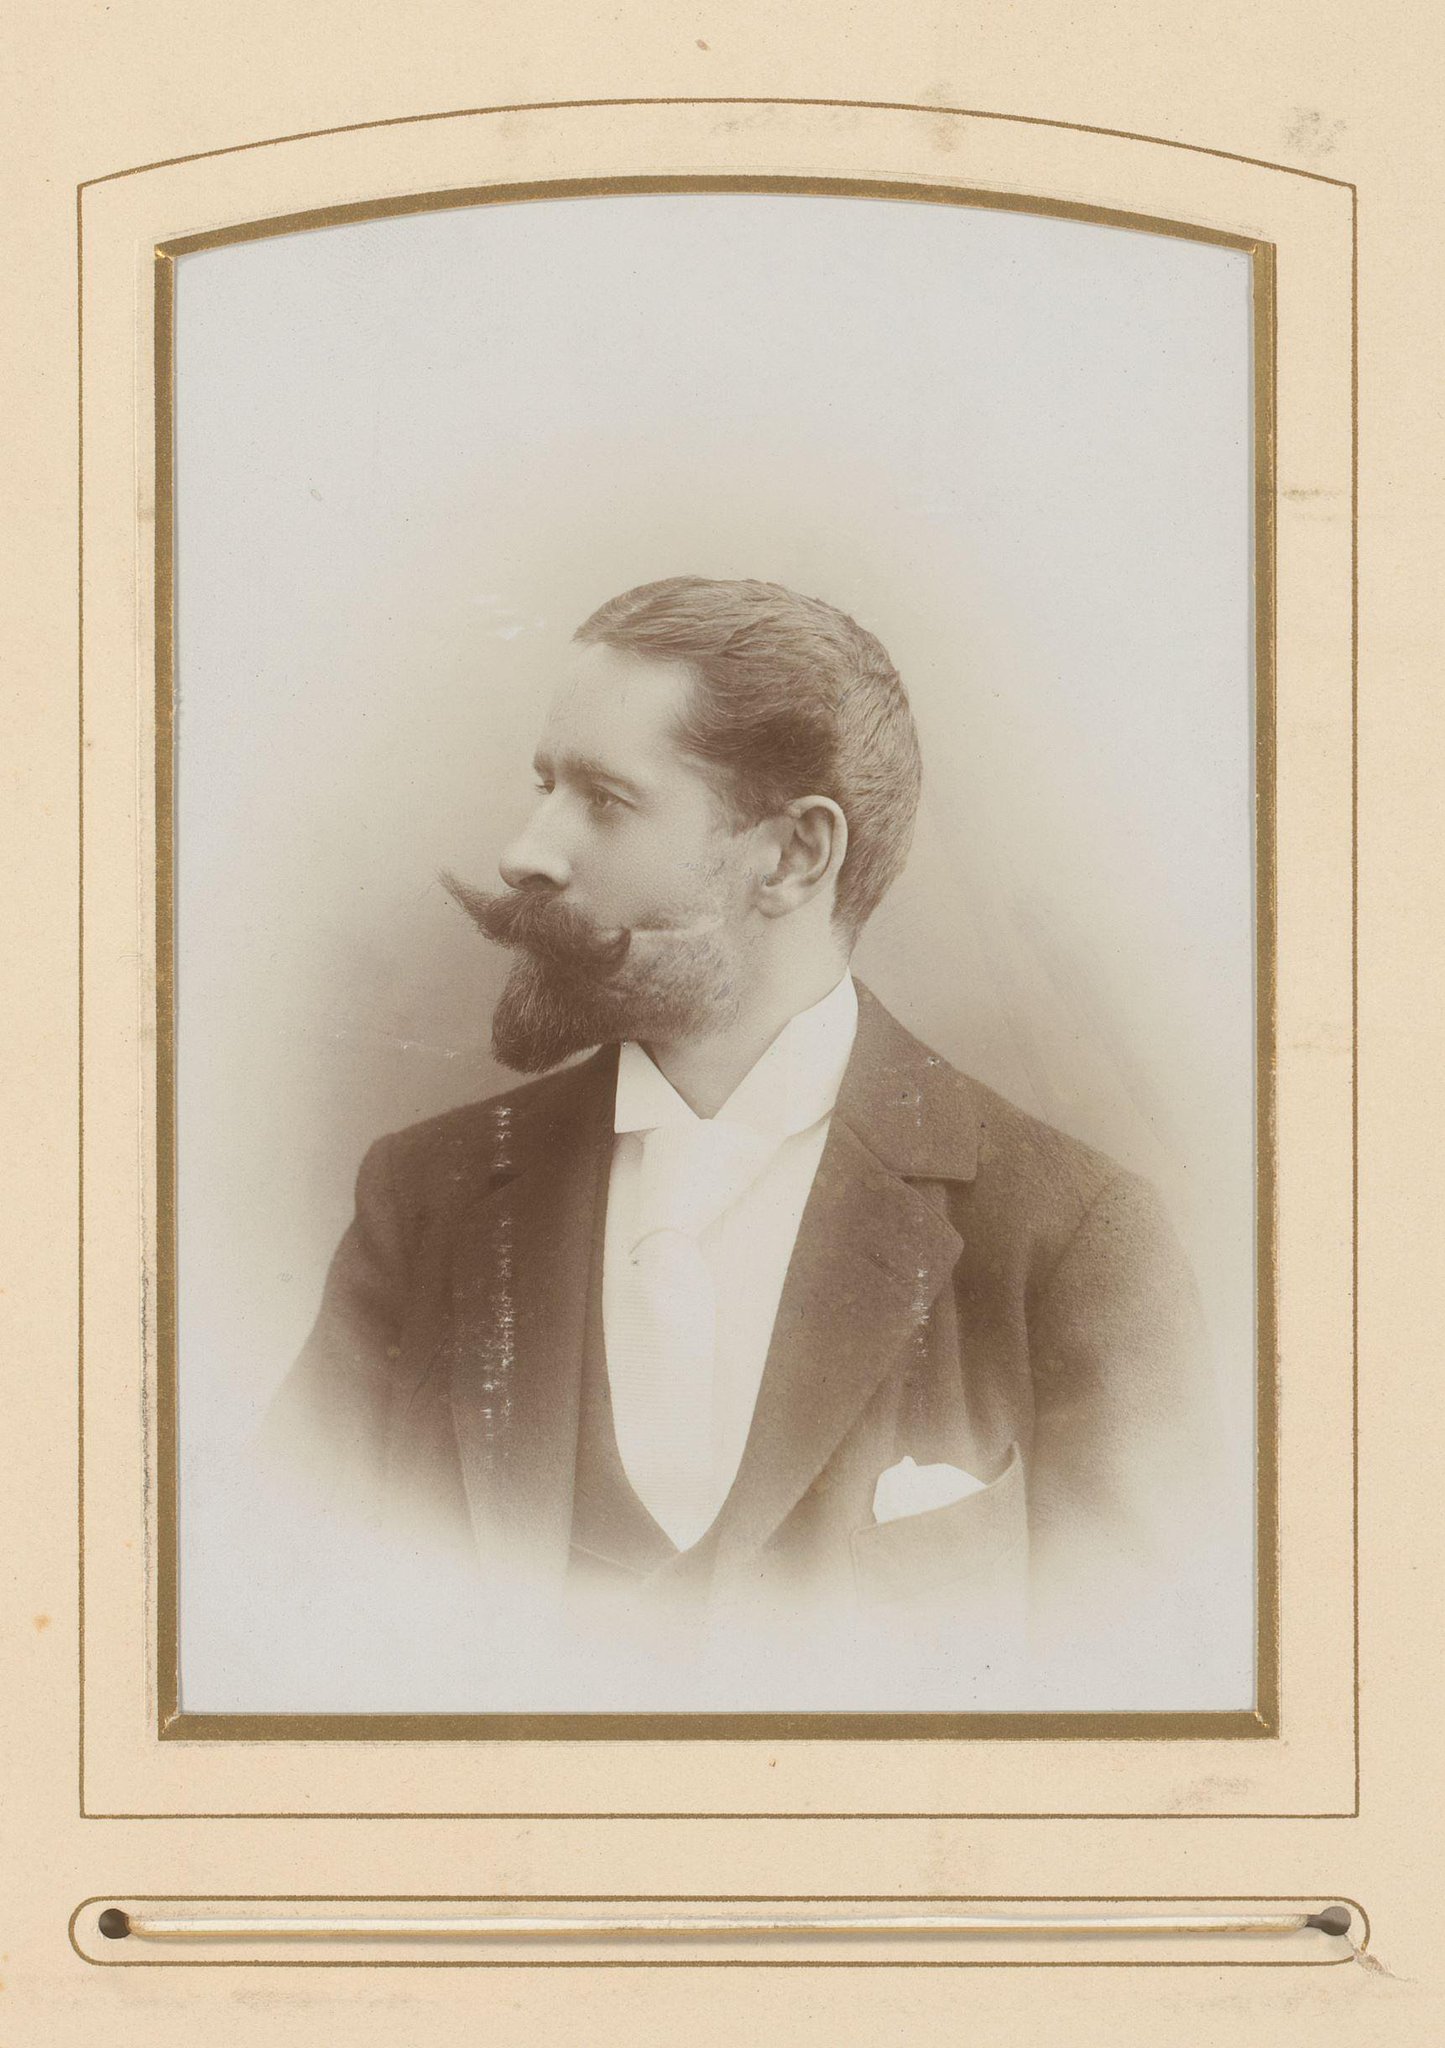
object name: photograph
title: Portret van een man met snor en baard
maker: adolf wohlbach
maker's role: fotograaf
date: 1880-1920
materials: cardboard, photographic support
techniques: collodion silver print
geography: coburg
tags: moustache, historical persons, beard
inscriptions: inscription: ‘A. Wohlbach/ Photogr. Atelier/ Coburg/ Ernst-Platz 8./ Die Platte bleibt zut Nachbestellung aufbewahrt./ Vergrösserungen nach diesem, sowie jedem anderen Bilde/ in feinster Ausführung.’